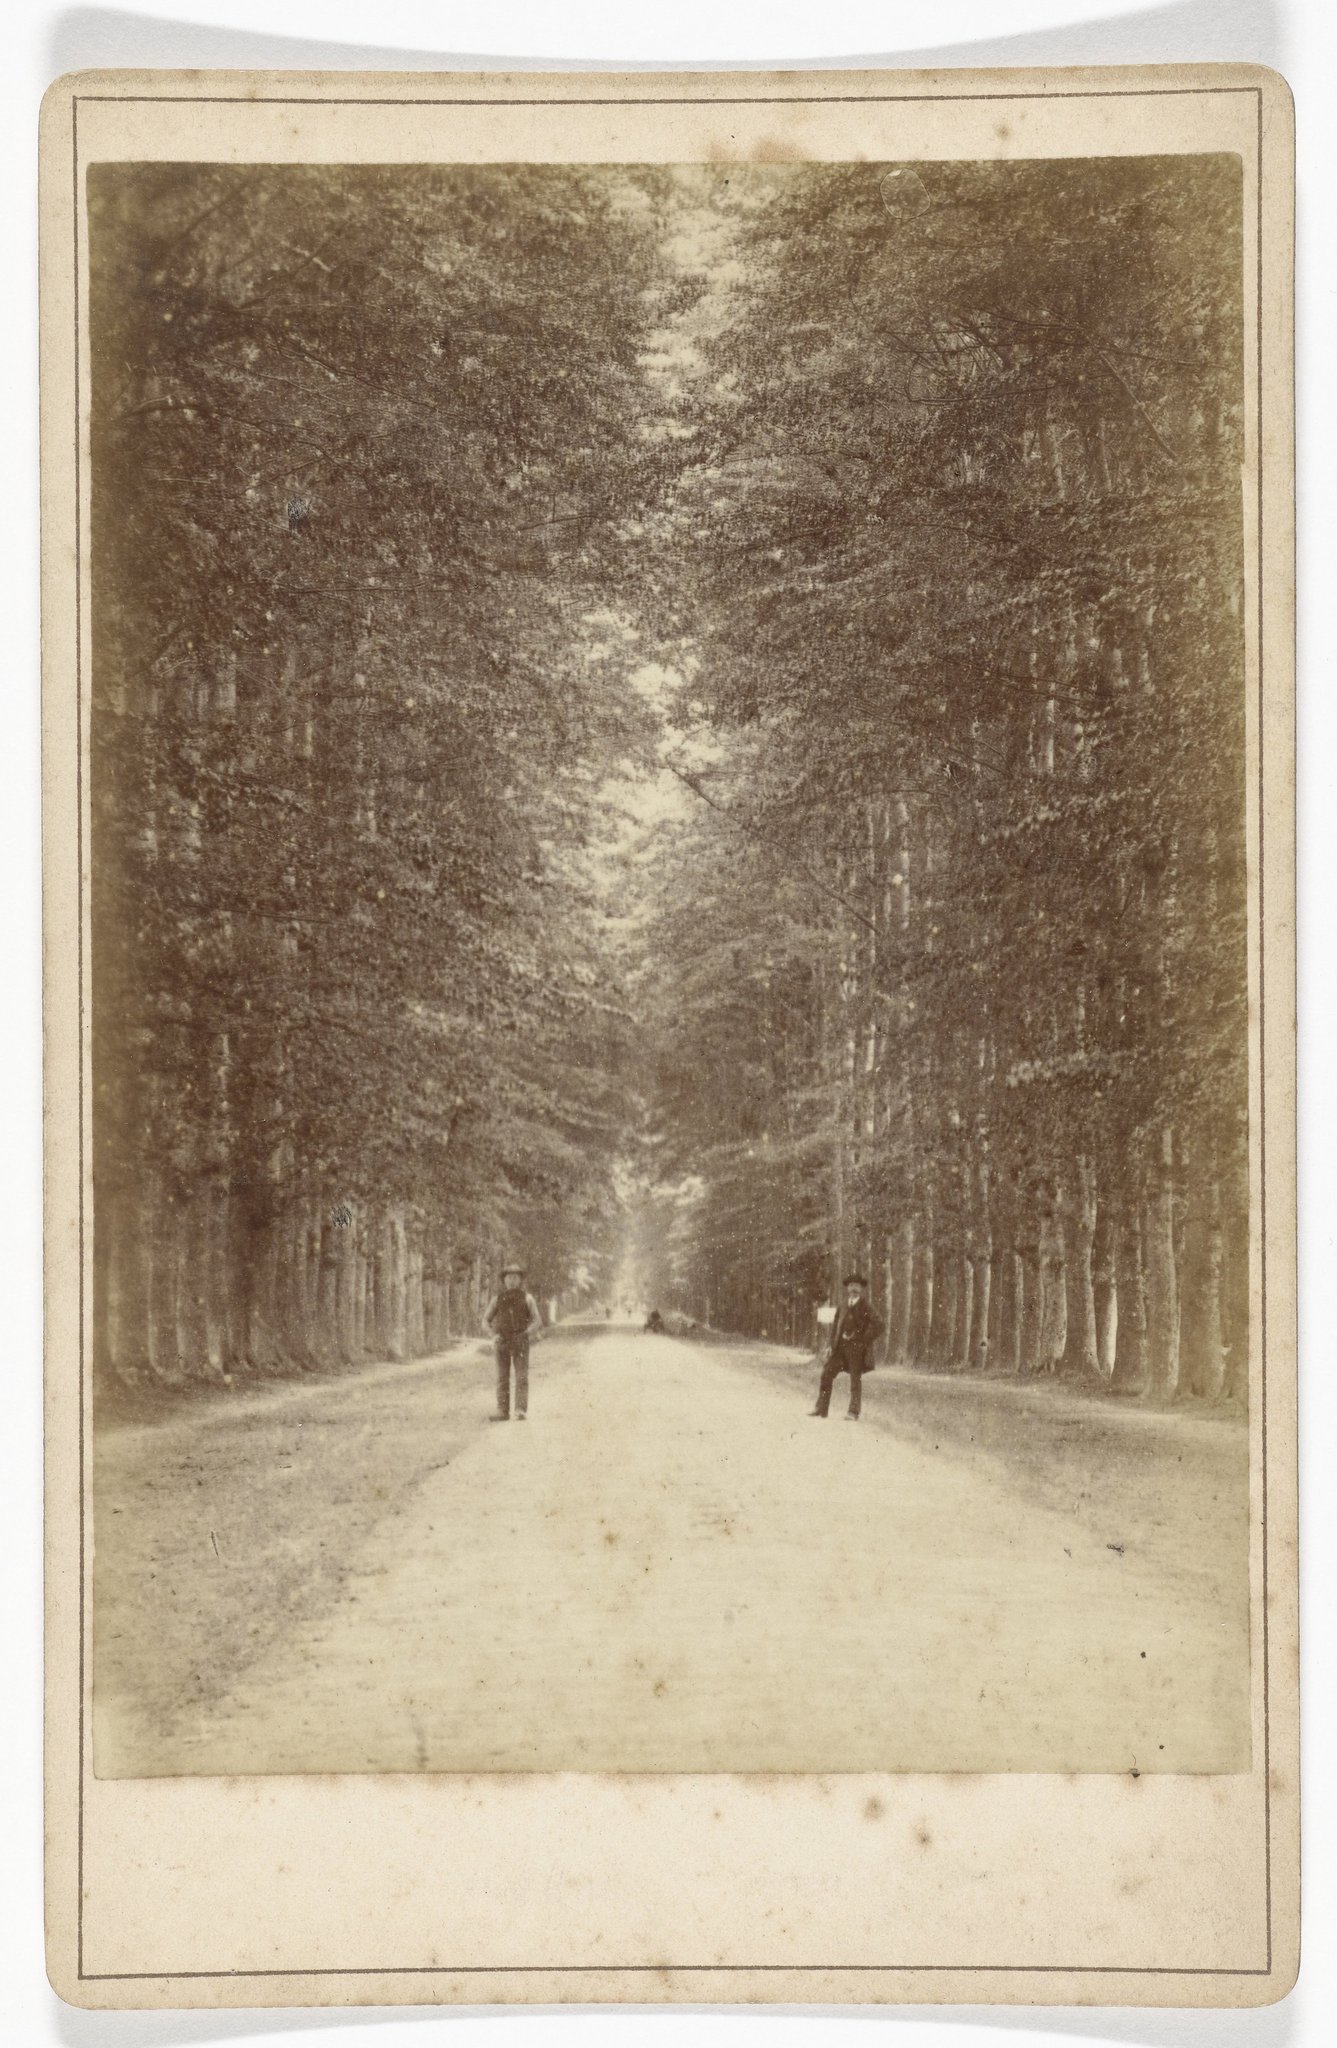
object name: photograph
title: Middachter allée bij de STEEG.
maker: j.s.j. de jongh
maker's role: fotograaf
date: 1860-1890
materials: cardboard, paper, photographic support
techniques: albumen print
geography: arnhem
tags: forest, wood, lane, alley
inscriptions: annotation: ‘Middachter allée bij de STEEG.’, name: ‘Vosmaer’, signature: ‘J.S.J. de Jongh, Koningstraat 85 Arnhem’